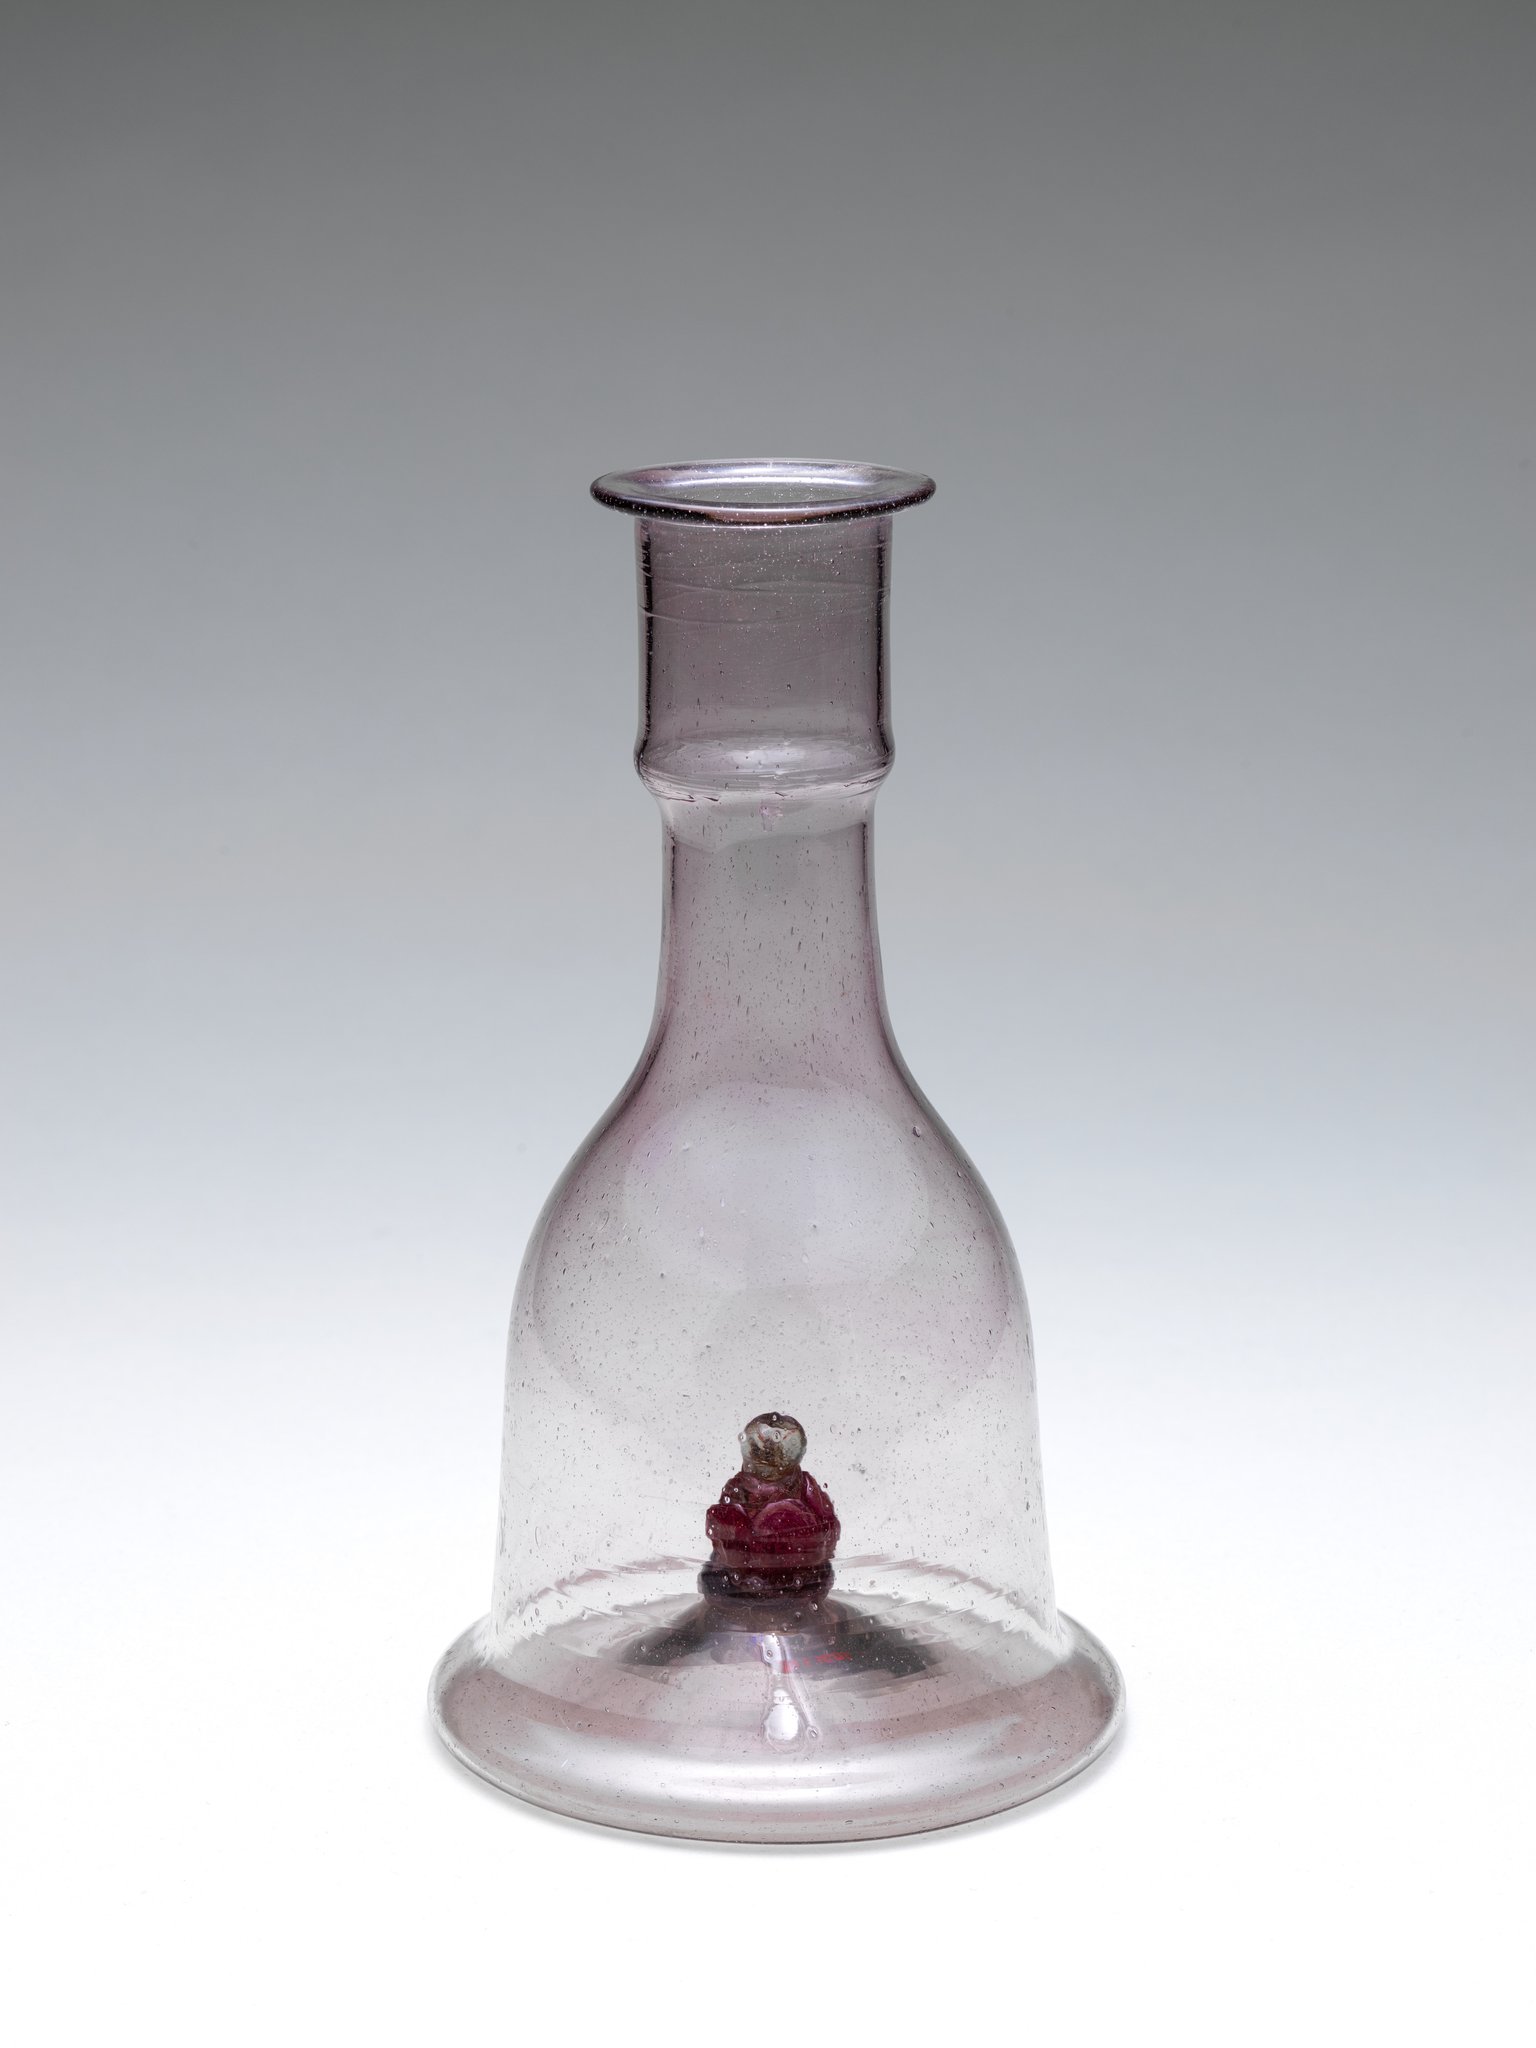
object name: water pipe base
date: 1701-1900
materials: glass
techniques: glassblowing, tooling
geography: iran